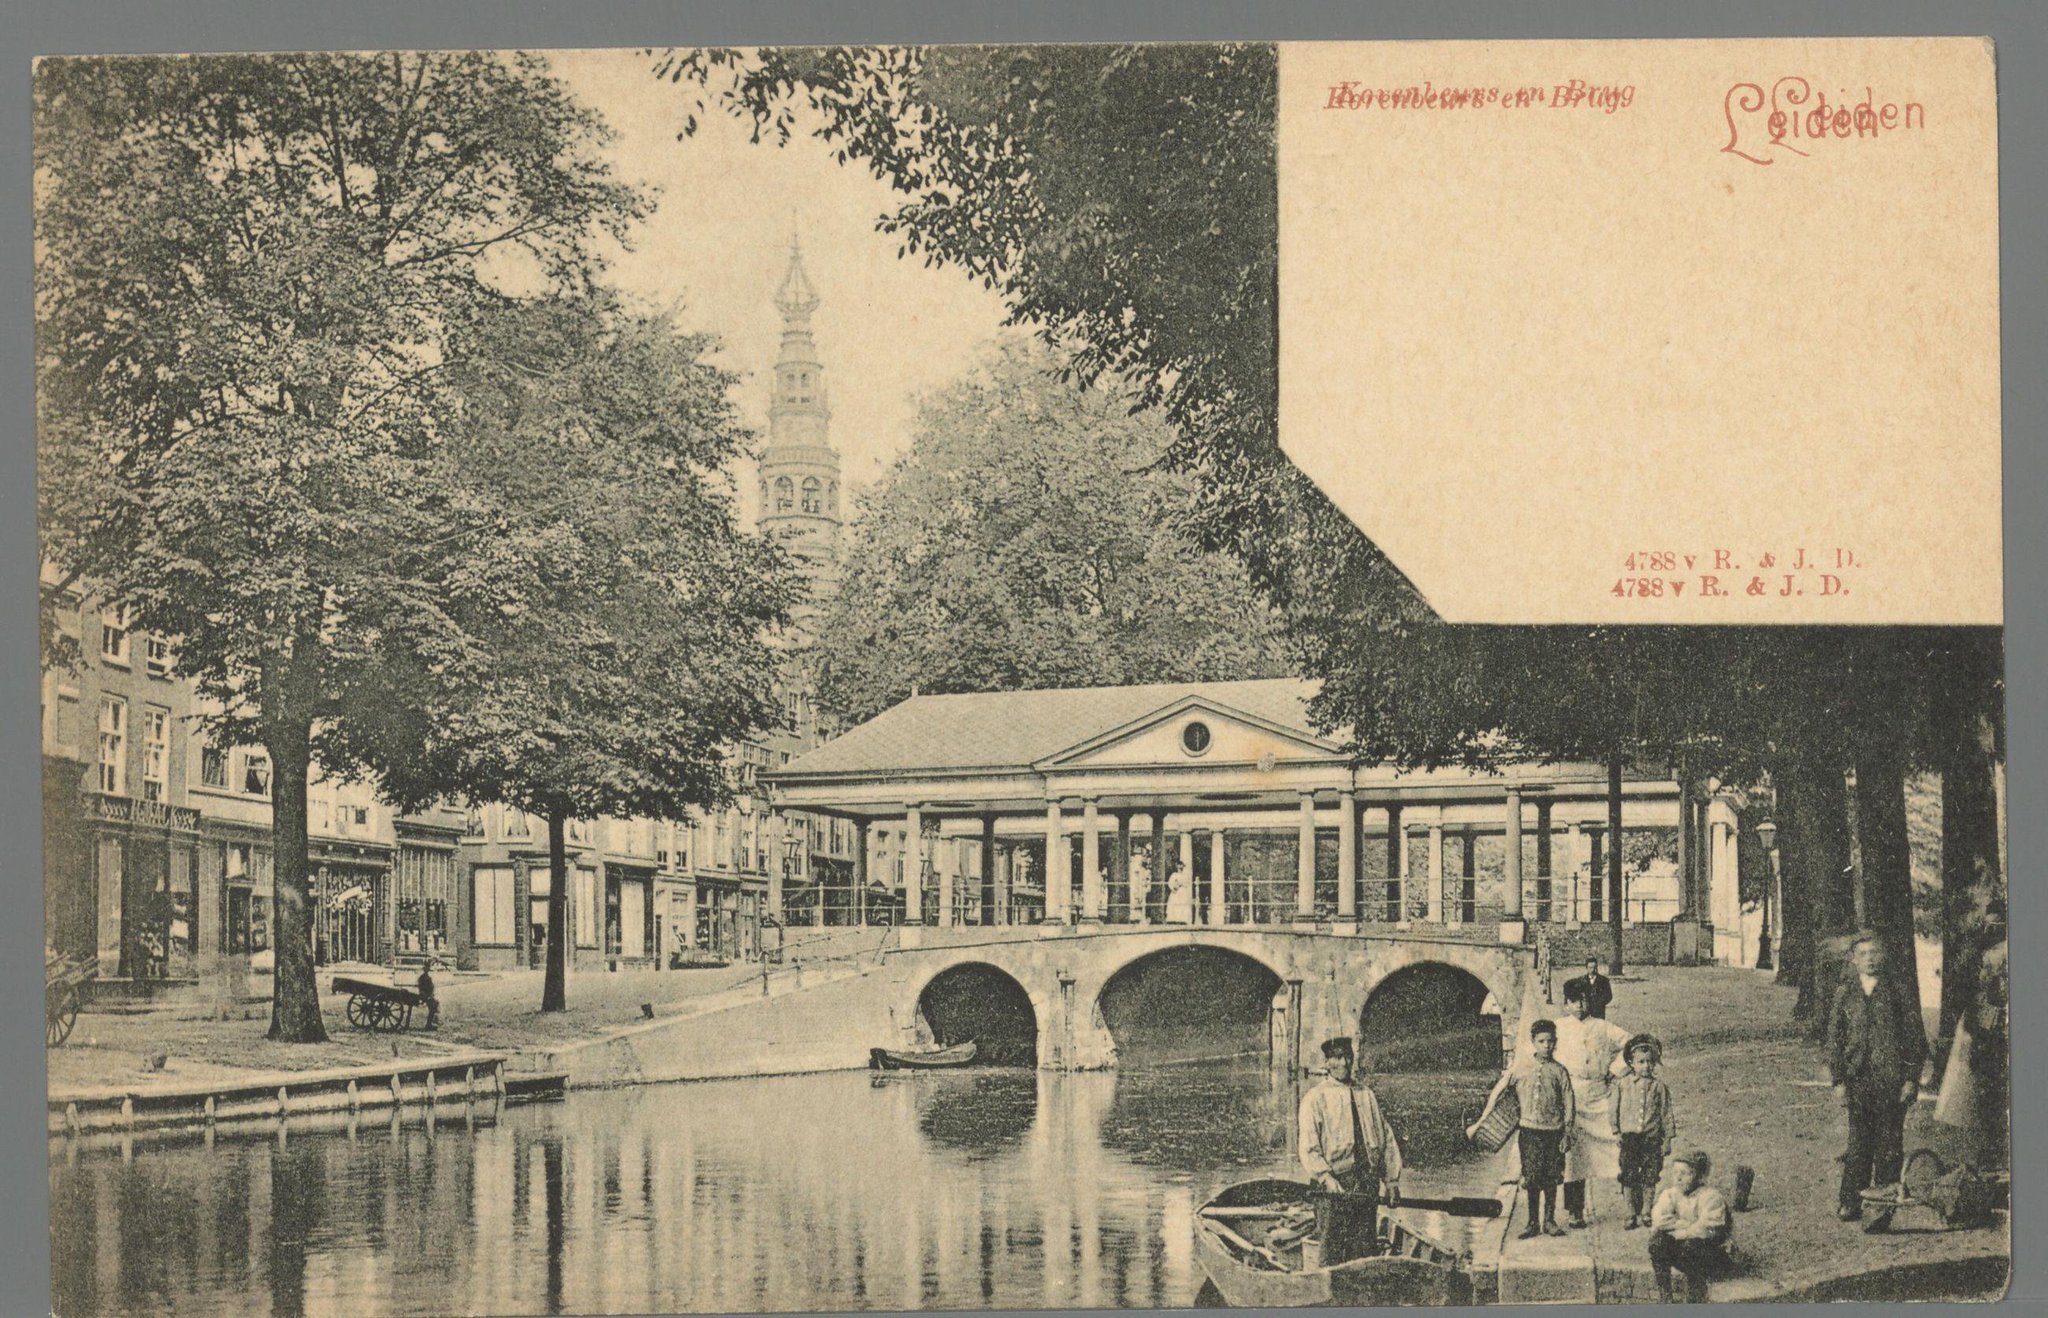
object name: ansichtkaart, prentbriefkaart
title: Korenbeurs en brug. Leiden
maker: Anonymous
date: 1892-1905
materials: cardboard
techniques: photograph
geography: leiden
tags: canal, church (exterior), bridge in city across river, canal, etc.